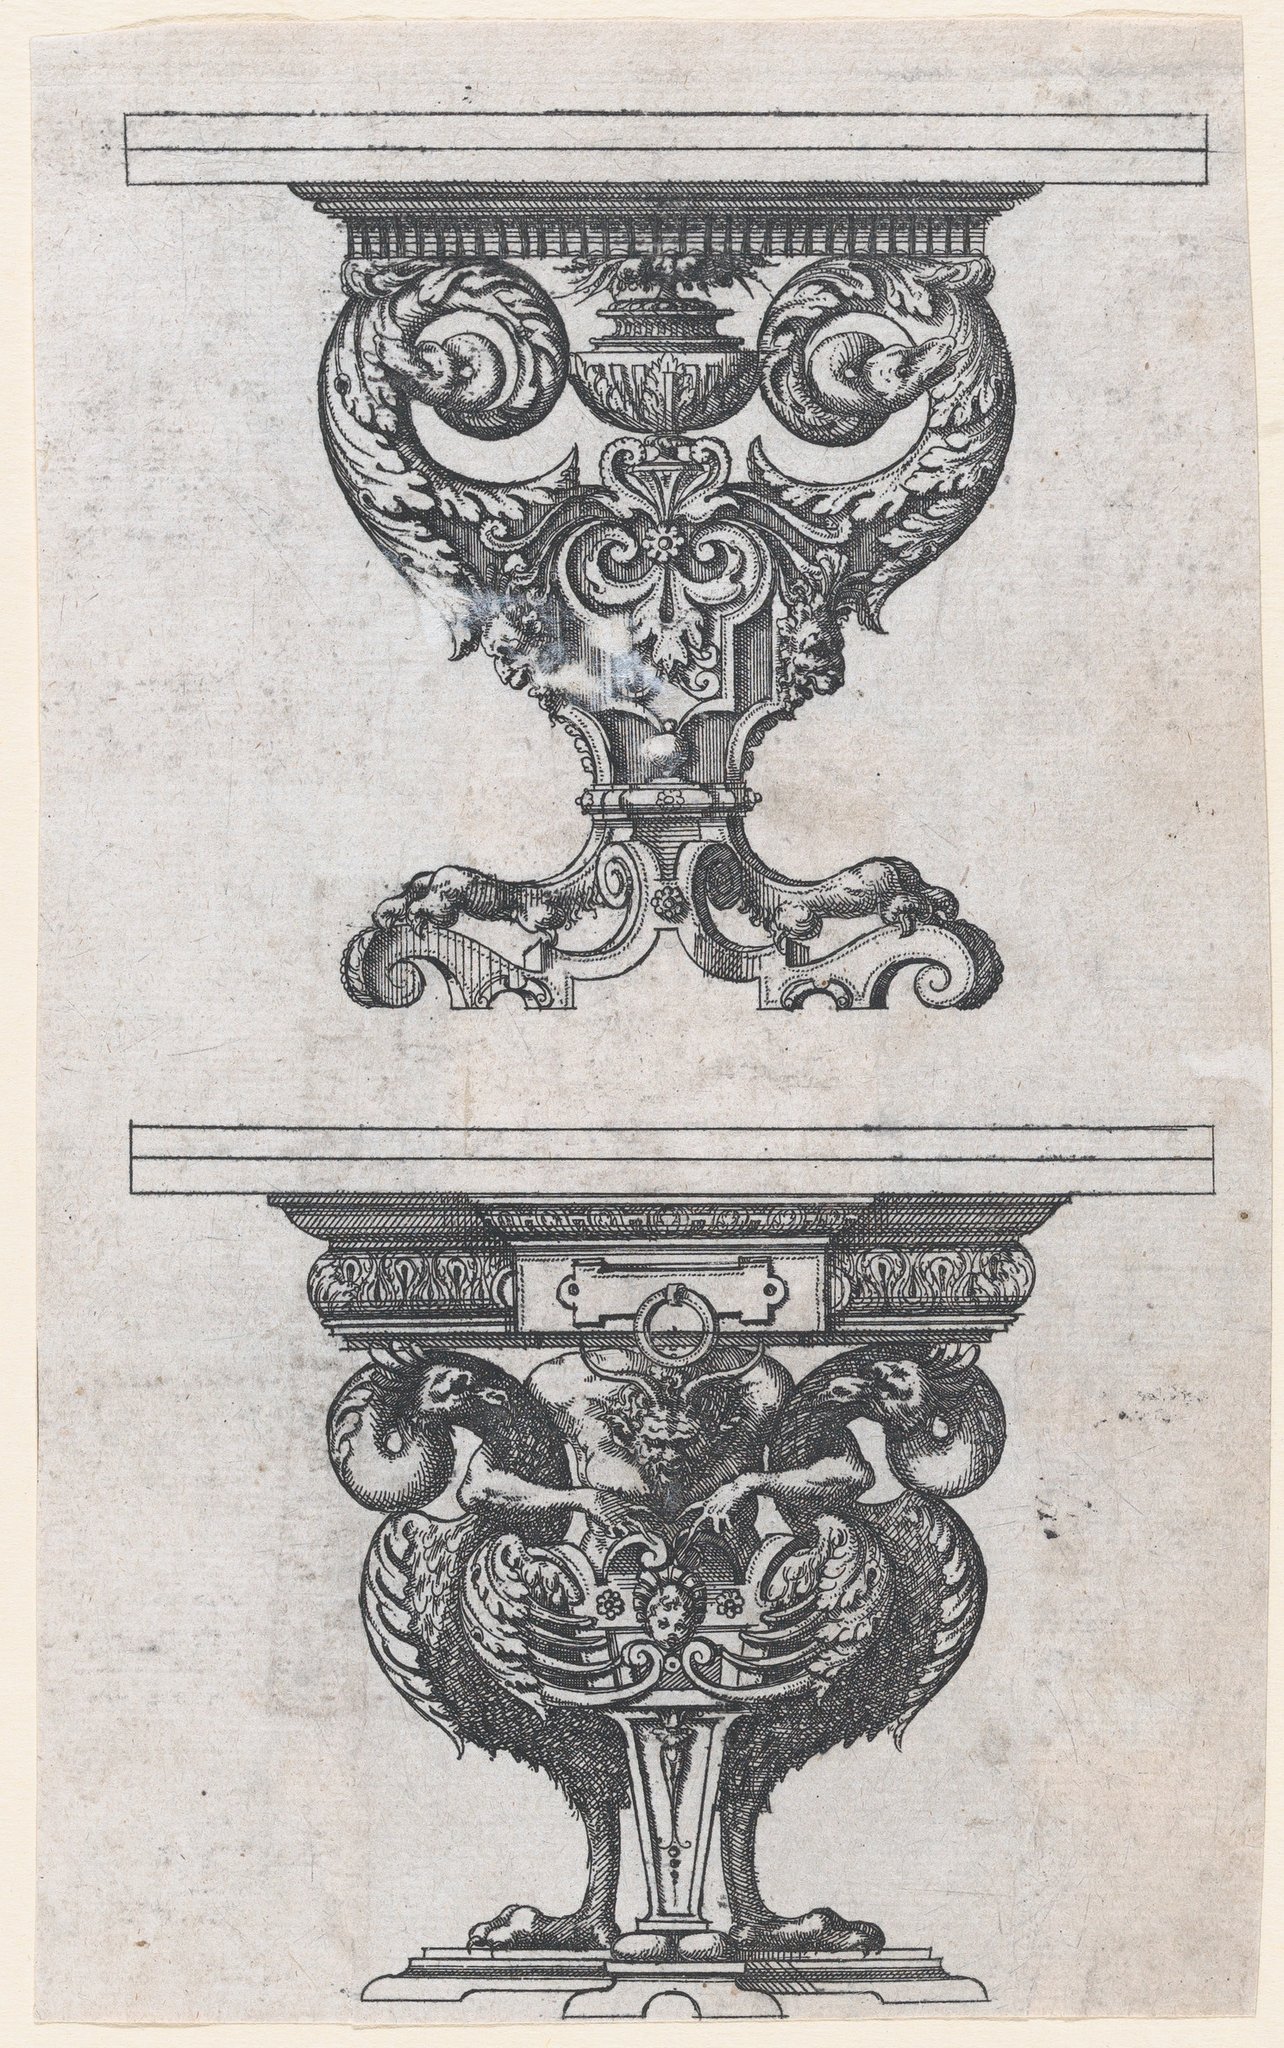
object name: print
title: Two Table Designs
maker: jacques androuet du cerceau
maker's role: artist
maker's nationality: french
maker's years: 1510-1585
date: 1565-1570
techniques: etching